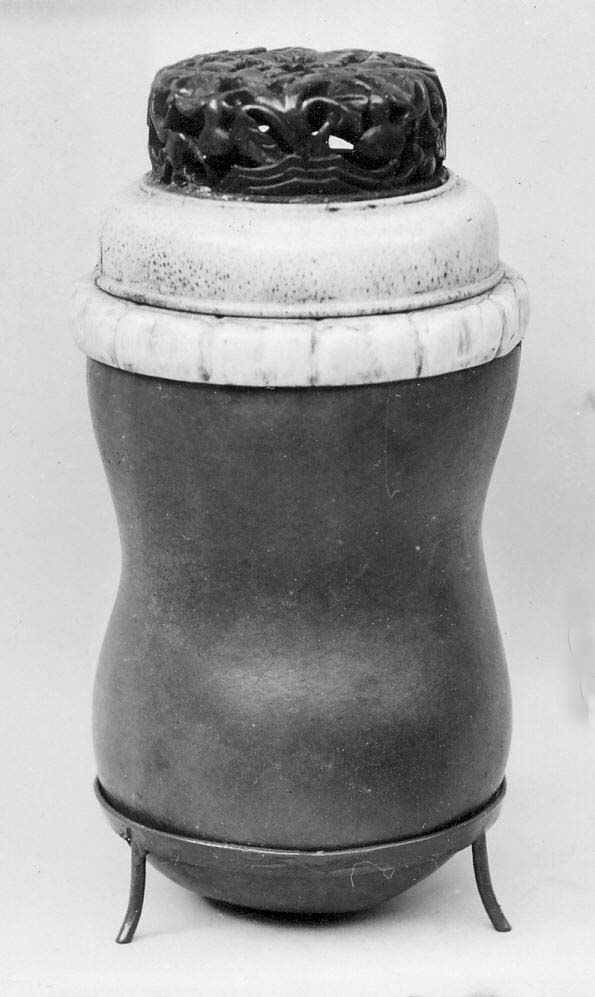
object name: cricket cage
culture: chinese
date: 1701-1900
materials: ivory